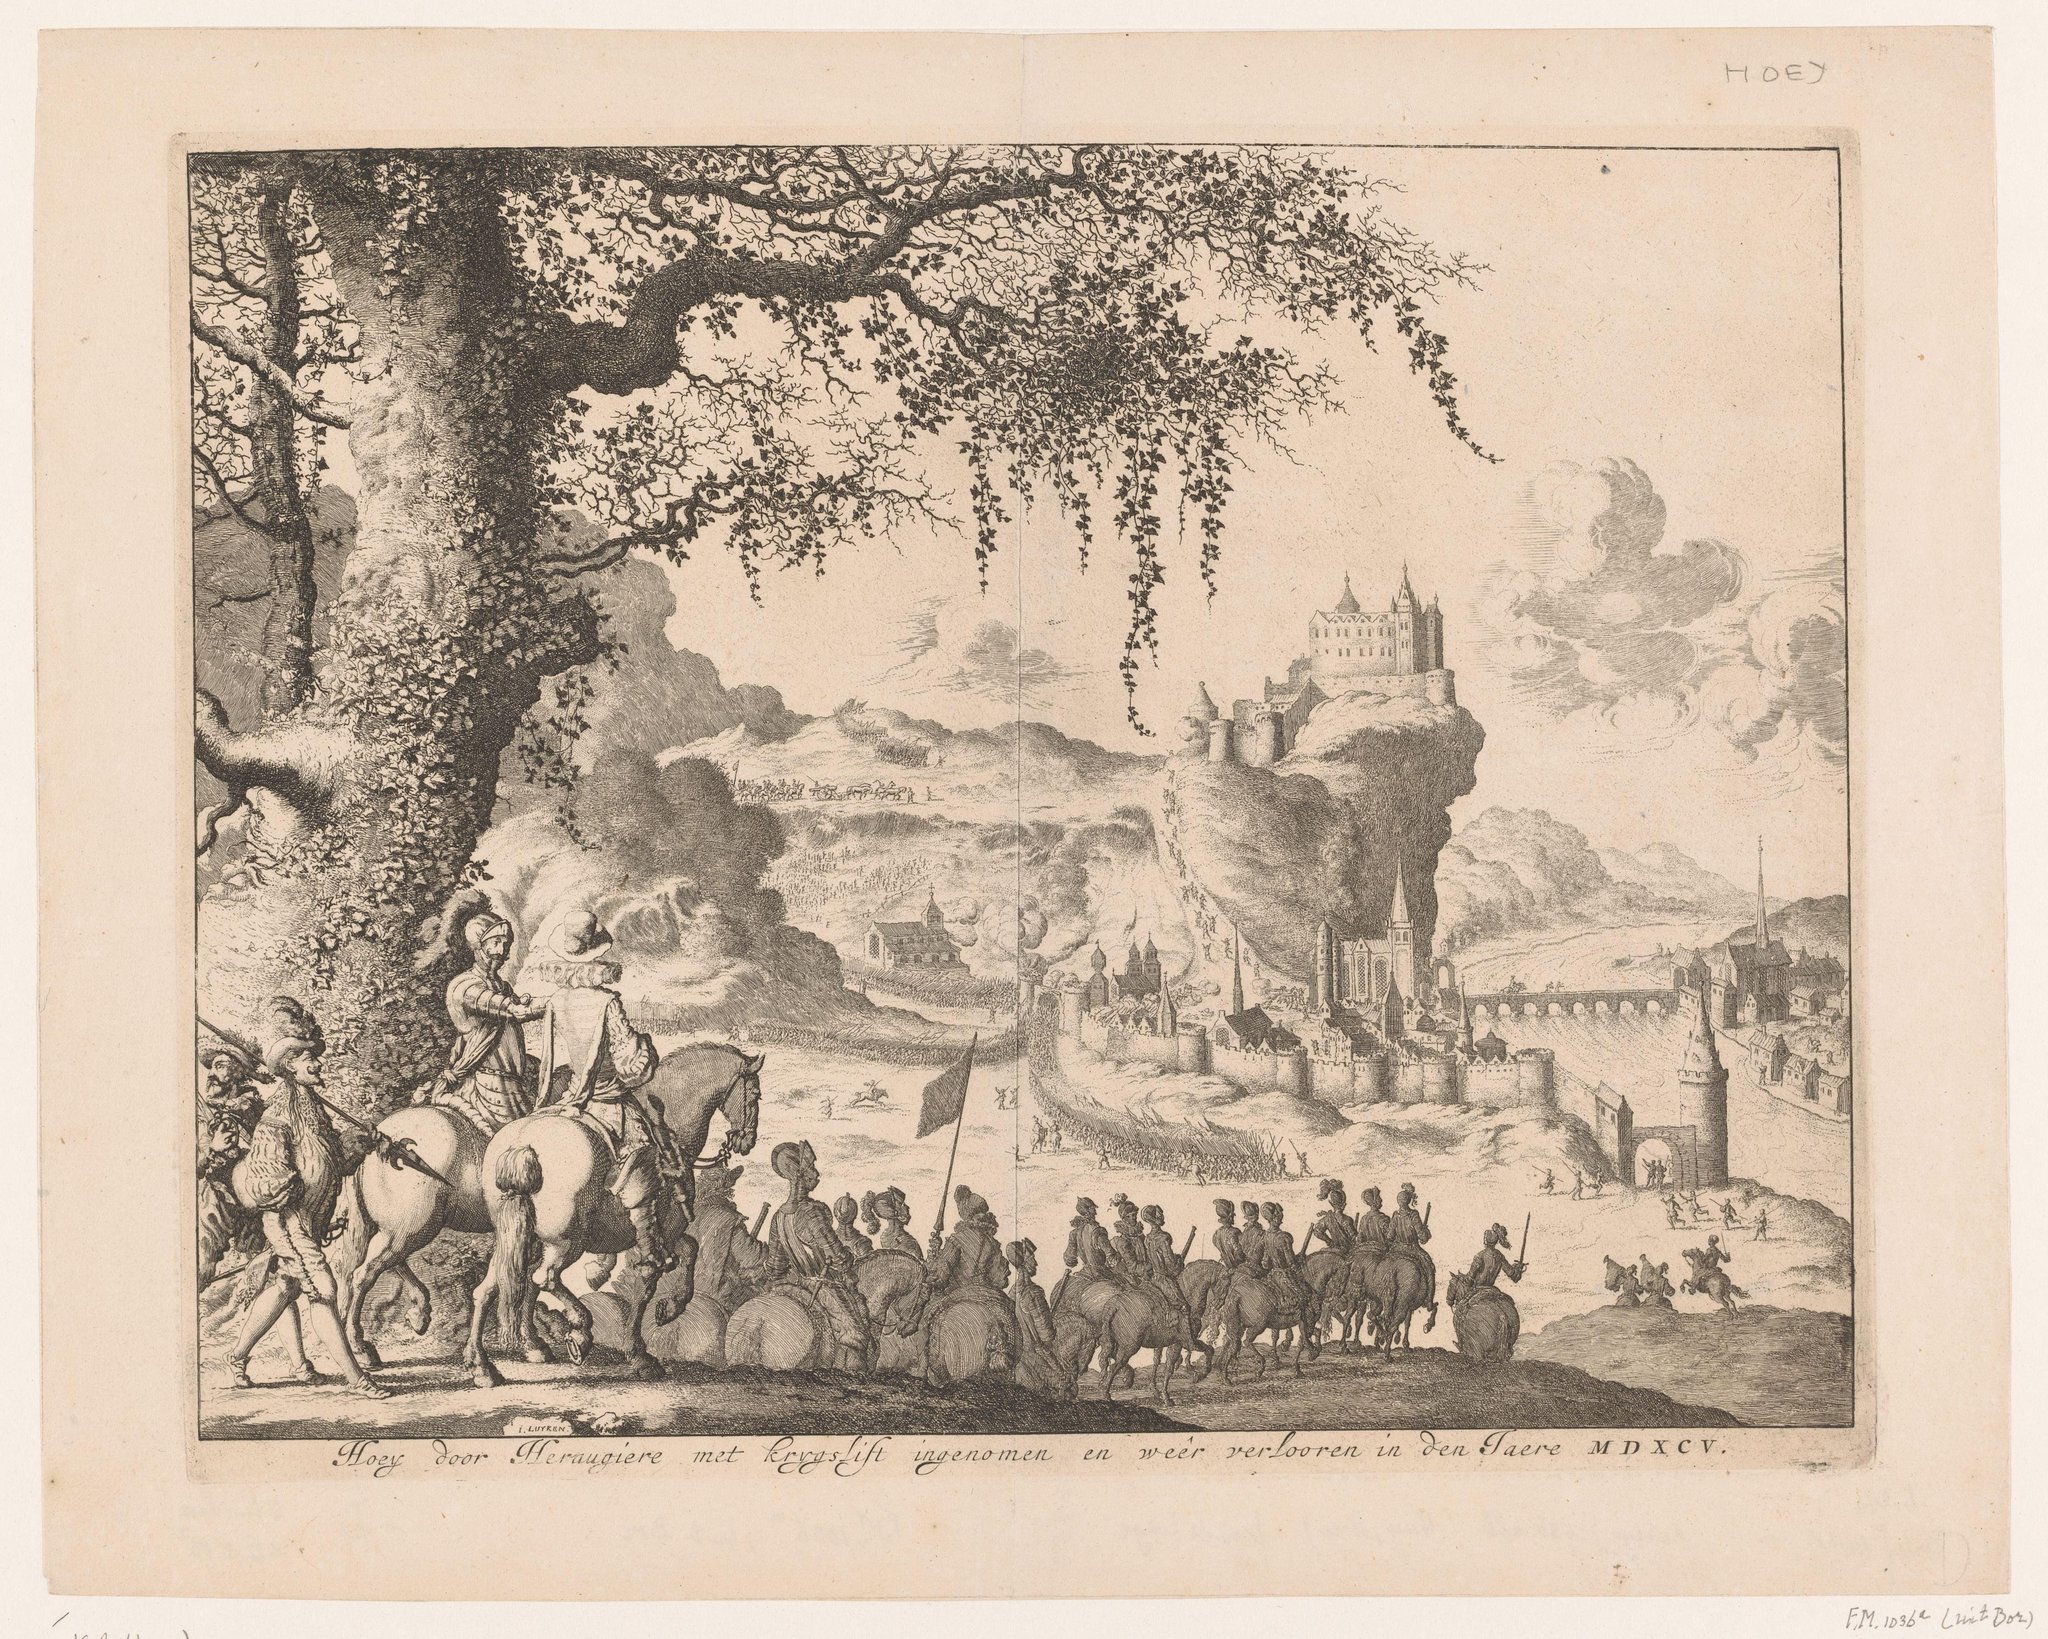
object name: book illustration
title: Inname van Hoei door Charles de Heraugières in 1595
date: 1684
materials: paper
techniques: etching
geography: amsterdam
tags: capture of city (after the siege)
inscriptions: collector's mark: Lugt 240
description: Prent uit: Bor, Pieter Christiaansz. Oorsprongk, begin en vervolgh der Nederlandsche oorlogen, beroerten, en borgerlyke oneenigheden (...). 4 dln. Amsterdam: Weduwe Johannes van Someren, Abraham Wolfgang en Hendrick en Dirck Boom, 1679, dl. 4, p. 10.